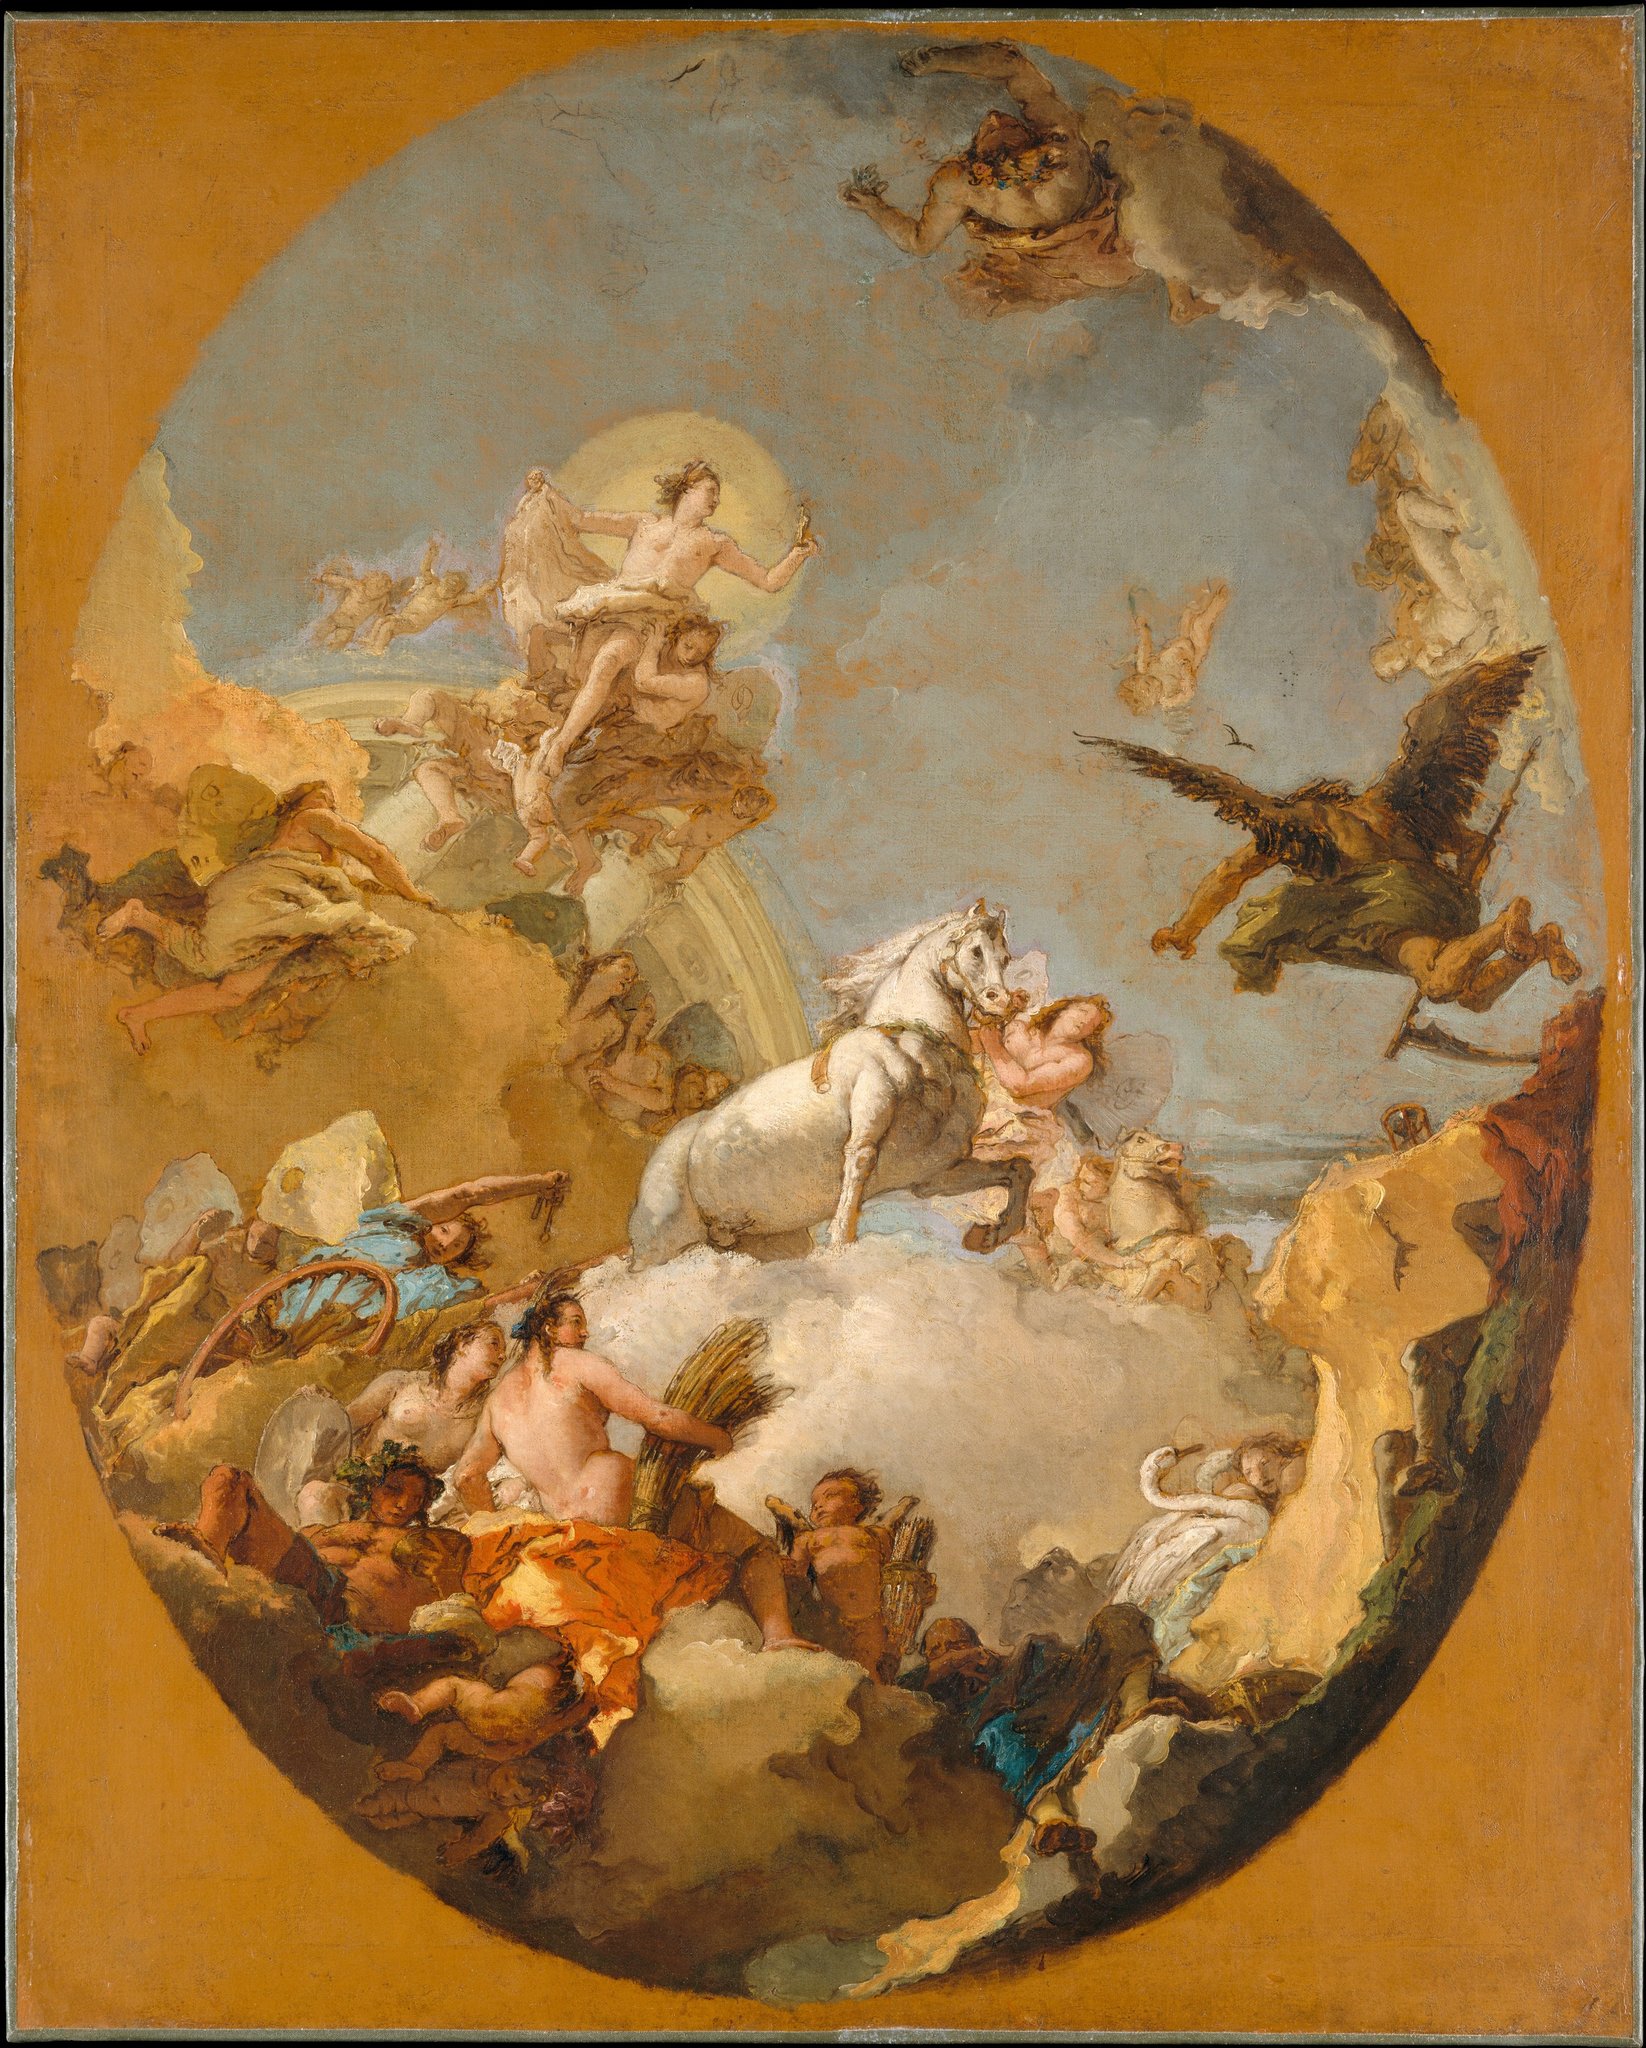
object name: painting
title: The Chariot of Aurora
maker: giovanni battista tiepolo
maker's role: artist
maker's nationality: italian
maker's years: 1696-1770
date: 1760-1769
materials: canvas, oil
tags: apollo,bacchus,swans,horses,goddess,chariots